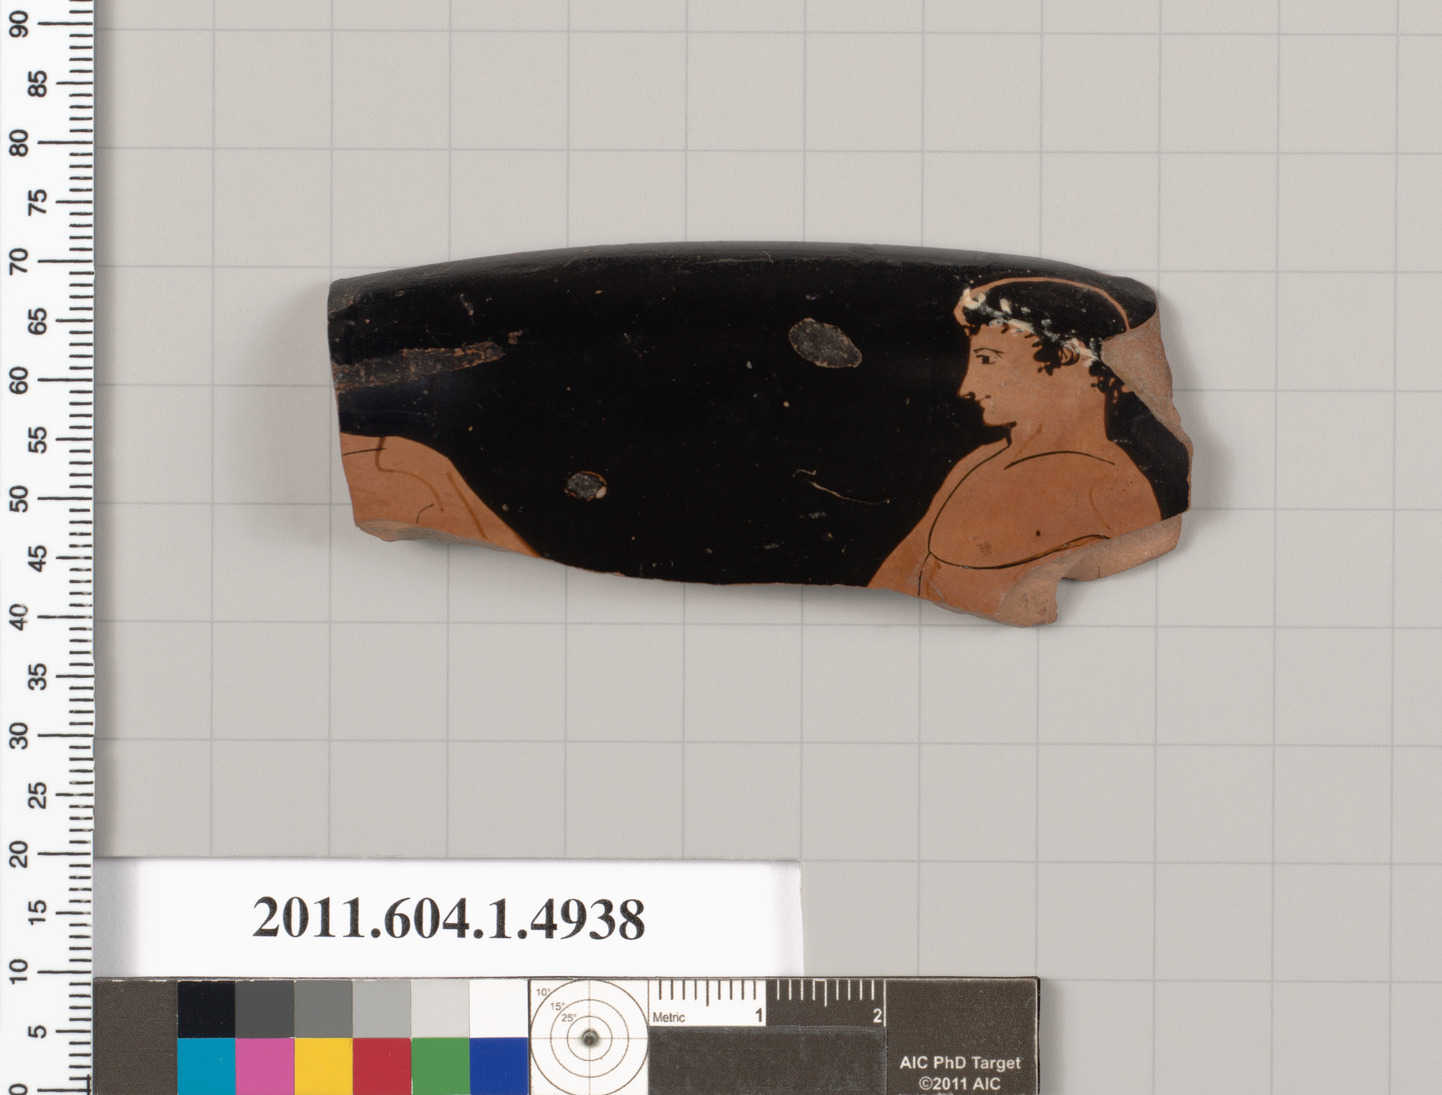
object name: kylix fragment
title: Terracotta rim fragment of a kylix (drinking cup)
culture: greek, attic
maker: calliope painter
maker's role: artist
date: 440-430 BCE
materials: terracotta